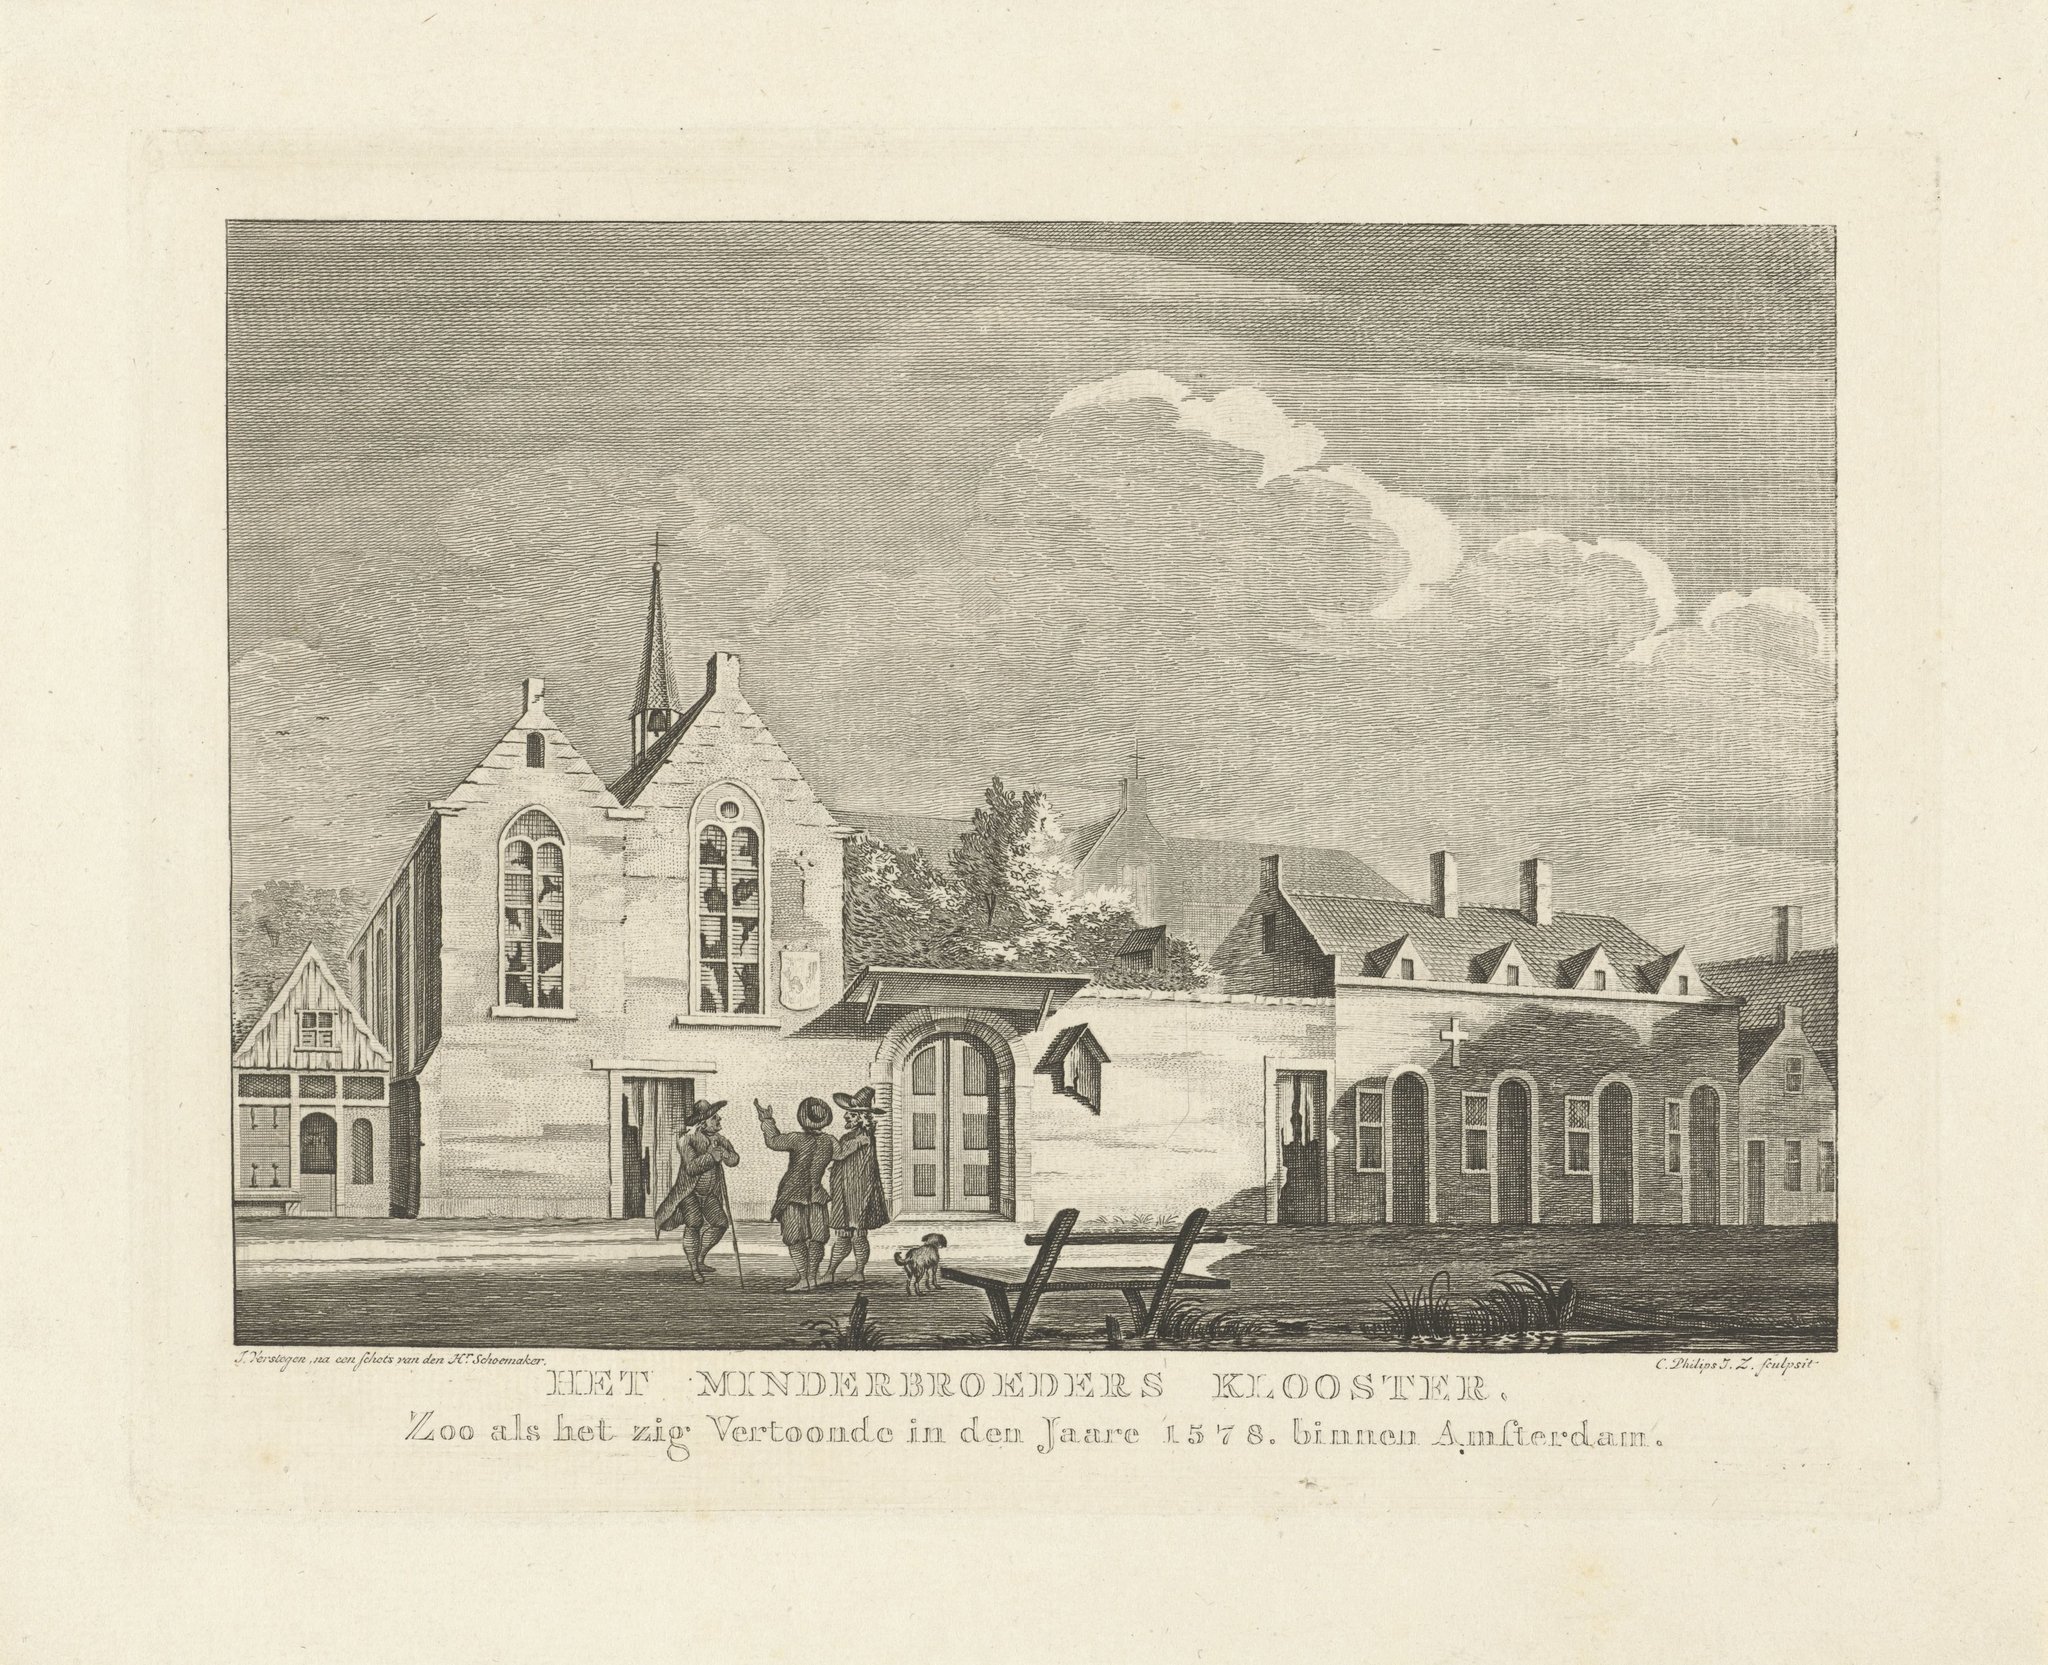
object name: print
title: Het Minderbroeders Klooster, Zoo als het zig Vertoonde in den Jaare 1578. binnen Amsterdam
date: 1752-1789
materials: paper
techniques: engraving, etching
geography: amsterdam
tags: abbey, monastery, convent ~ roman catholic church, plundering of churchbuilding, convent, etc.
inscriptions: collector's mark: Lugt 2228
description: Deze prent is ook ingebonden in enkele exemplaren van: Wagenaar, Jan. Amsterdam, in zyne opkomst, aanwas, geschiedenissen (…). 3 delen [folio-uitgave]. Amsterdam: Isaak Tirion en Yntema & Tieboel, 1760-1767, dl. 2 (Isaak Tirion, 1765). Komt echter niet voor in de lijst met in te binden prenten van deze uitgave (te vinden in dl. 3) - en is er dus ook niet voor bedoeld.